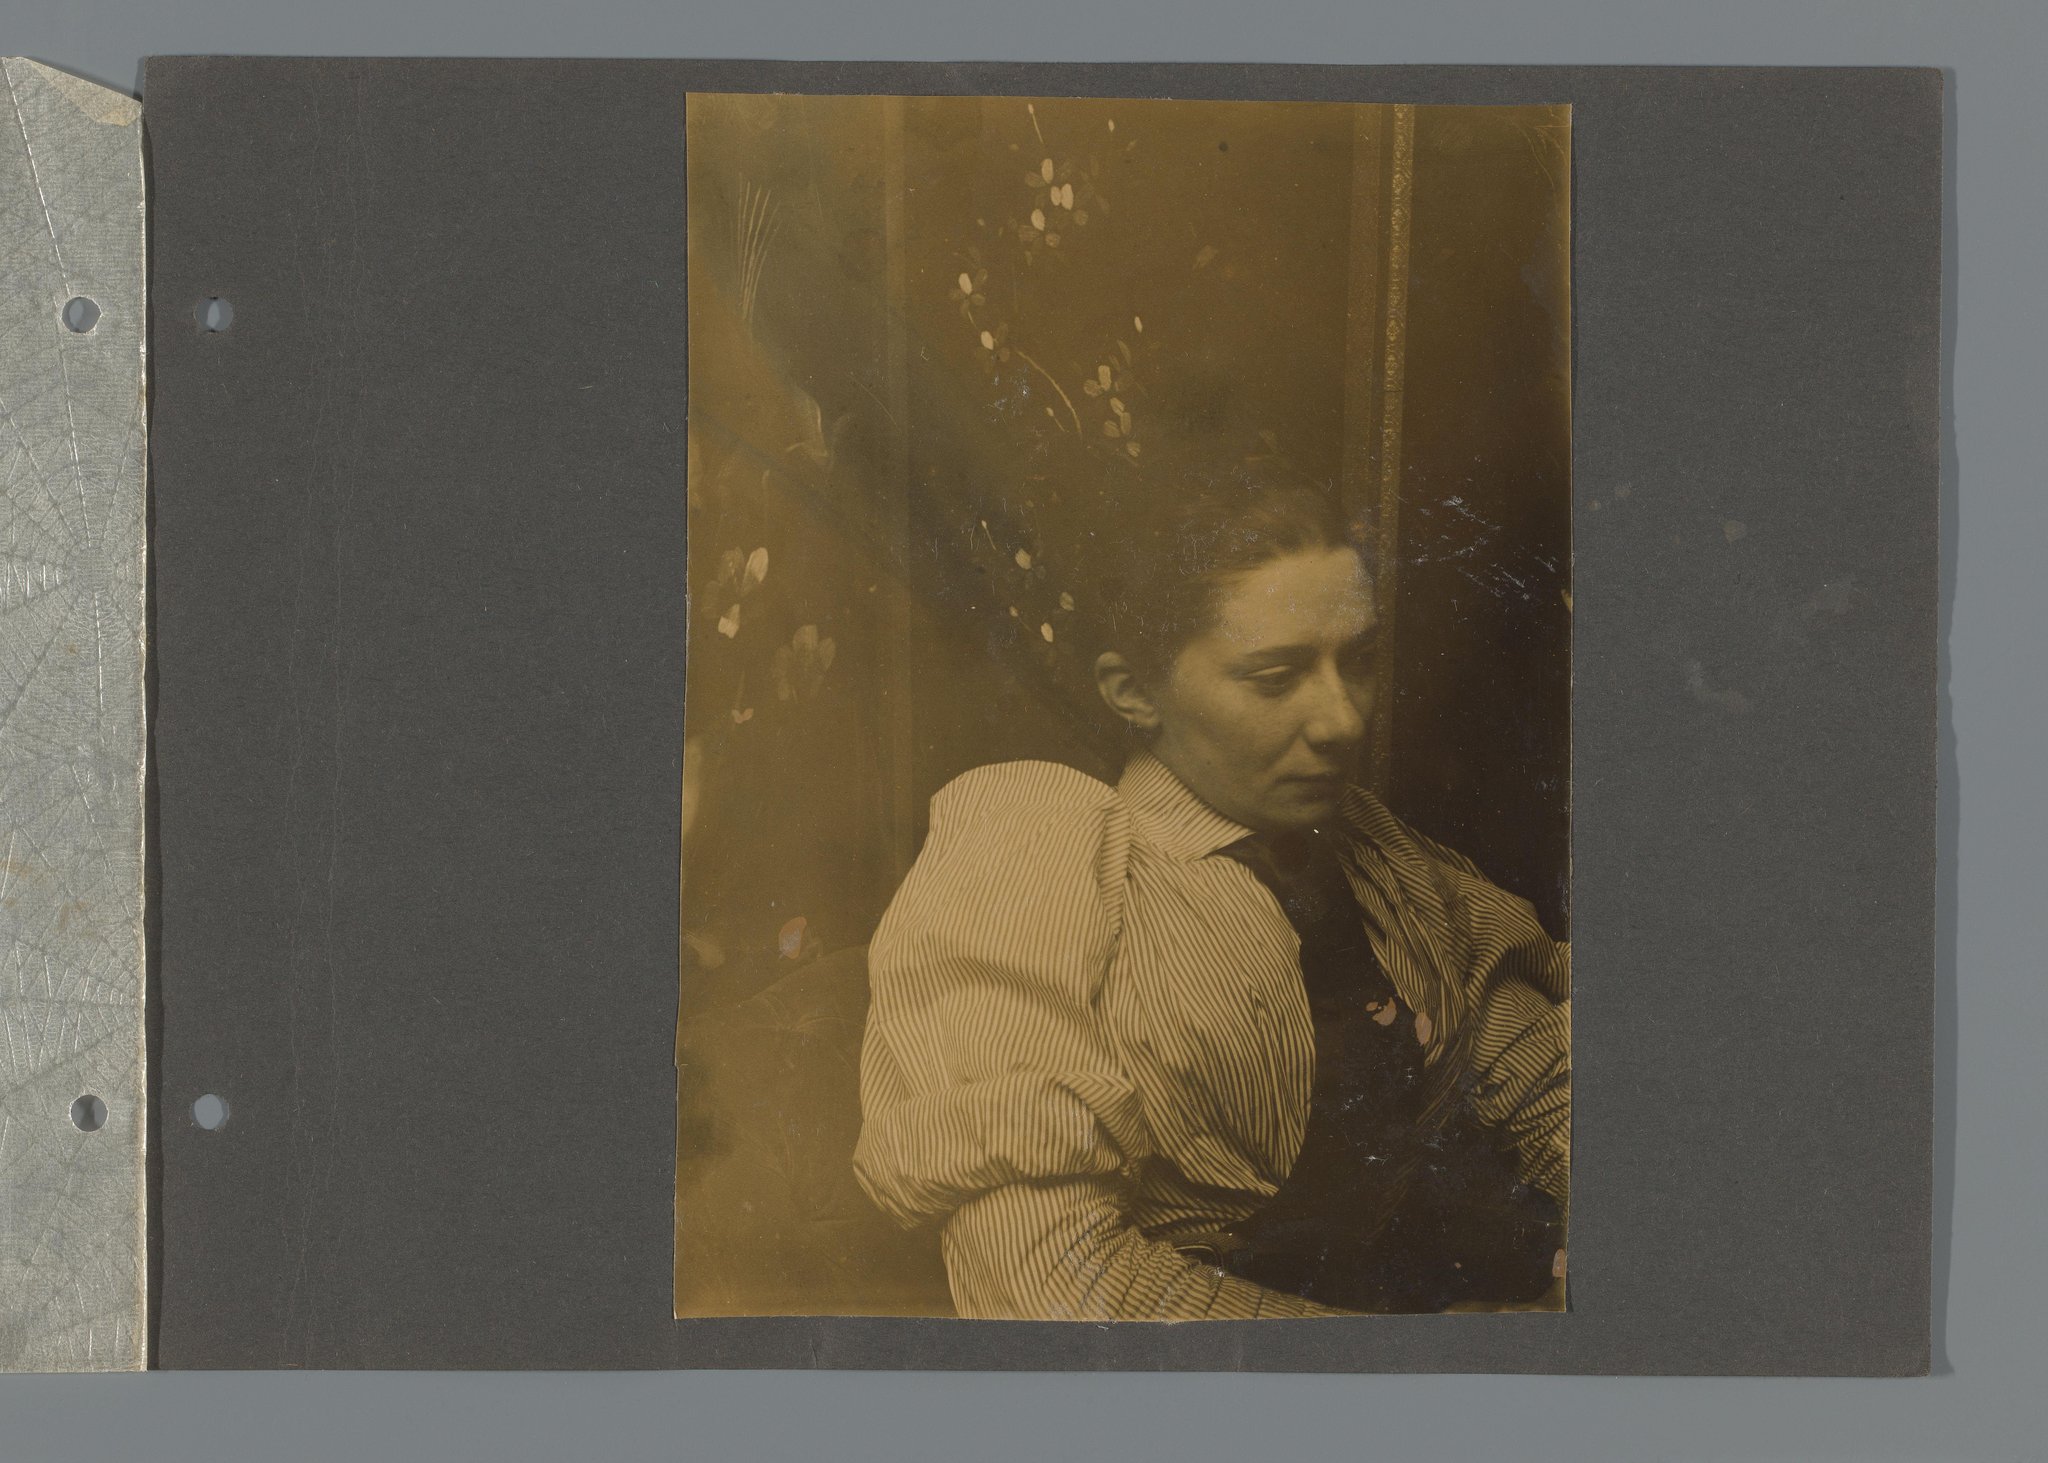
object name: photograph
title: Portret van Elsa Diepenbrock op albumblad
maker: wouterus gijsbertus hondius van den broek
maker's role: amateurfotograaf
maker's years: 1867-1913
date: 1888-1890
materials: photographic support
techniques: gelatin silver print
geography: netherlands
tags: elsa diepenbrock